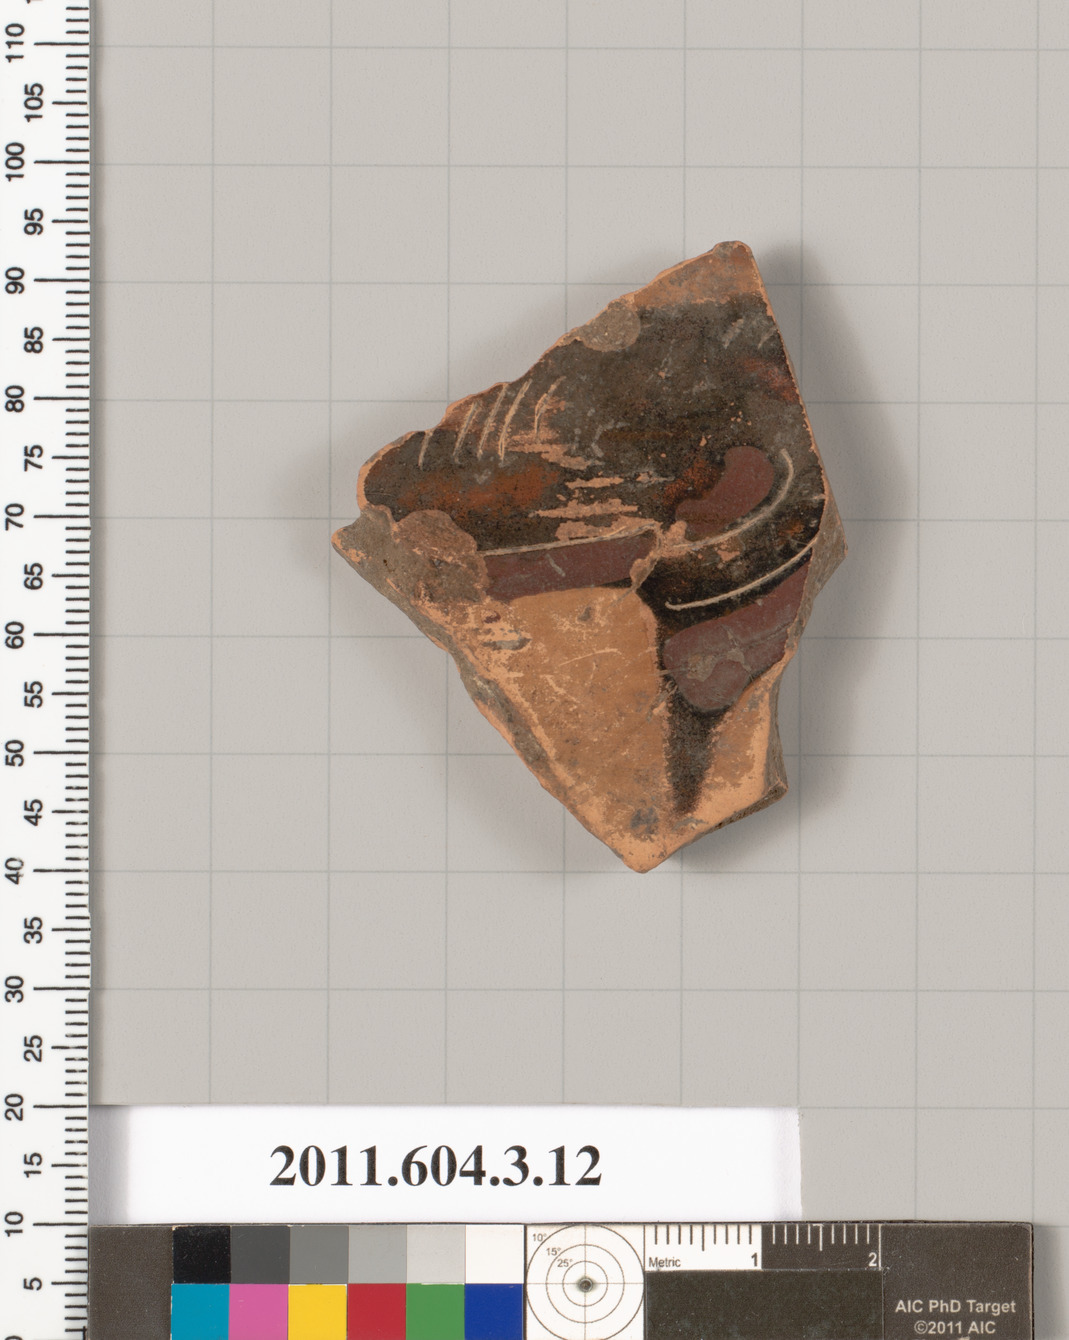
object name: undetermined open shape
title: Terracotta fragment of an open shape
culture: greek, attic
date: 600-501 BCE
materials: terracotta